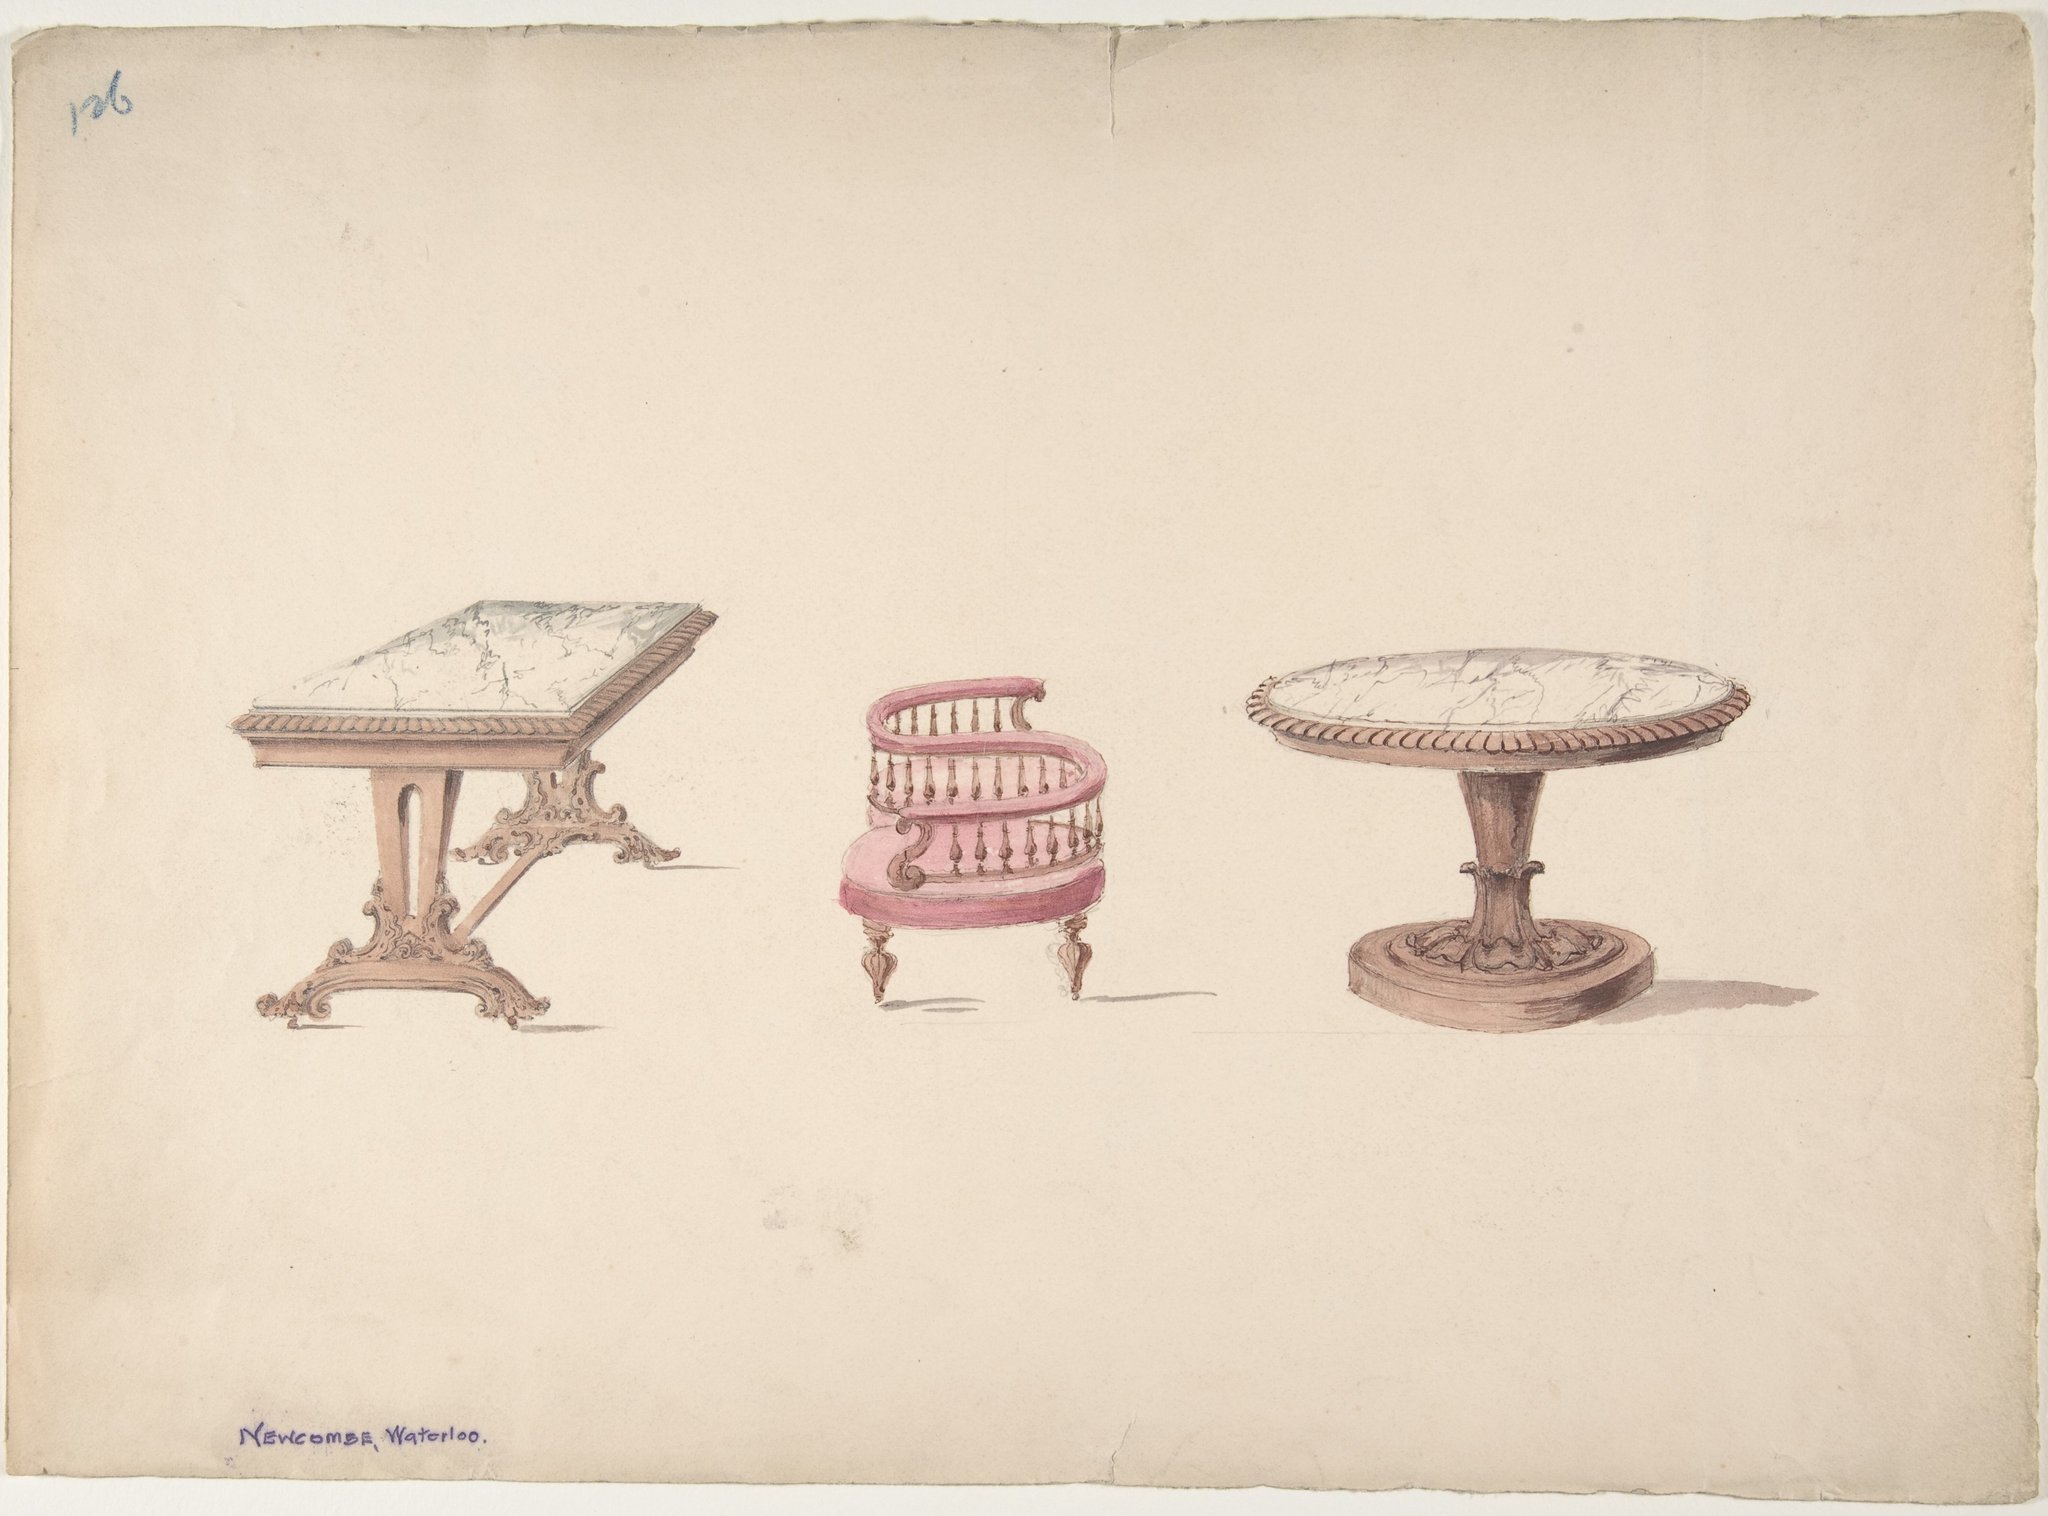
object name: drawing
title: Design for a Rectangular and Round Marble-topped Tables and a Tête-à Tête Chair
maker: anonymous, british, 19th century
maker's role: artist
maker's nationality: british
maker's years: 1800-1900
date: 1801-1833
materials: ink, watercolor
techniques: brush, pen, wash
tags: chairs,tables